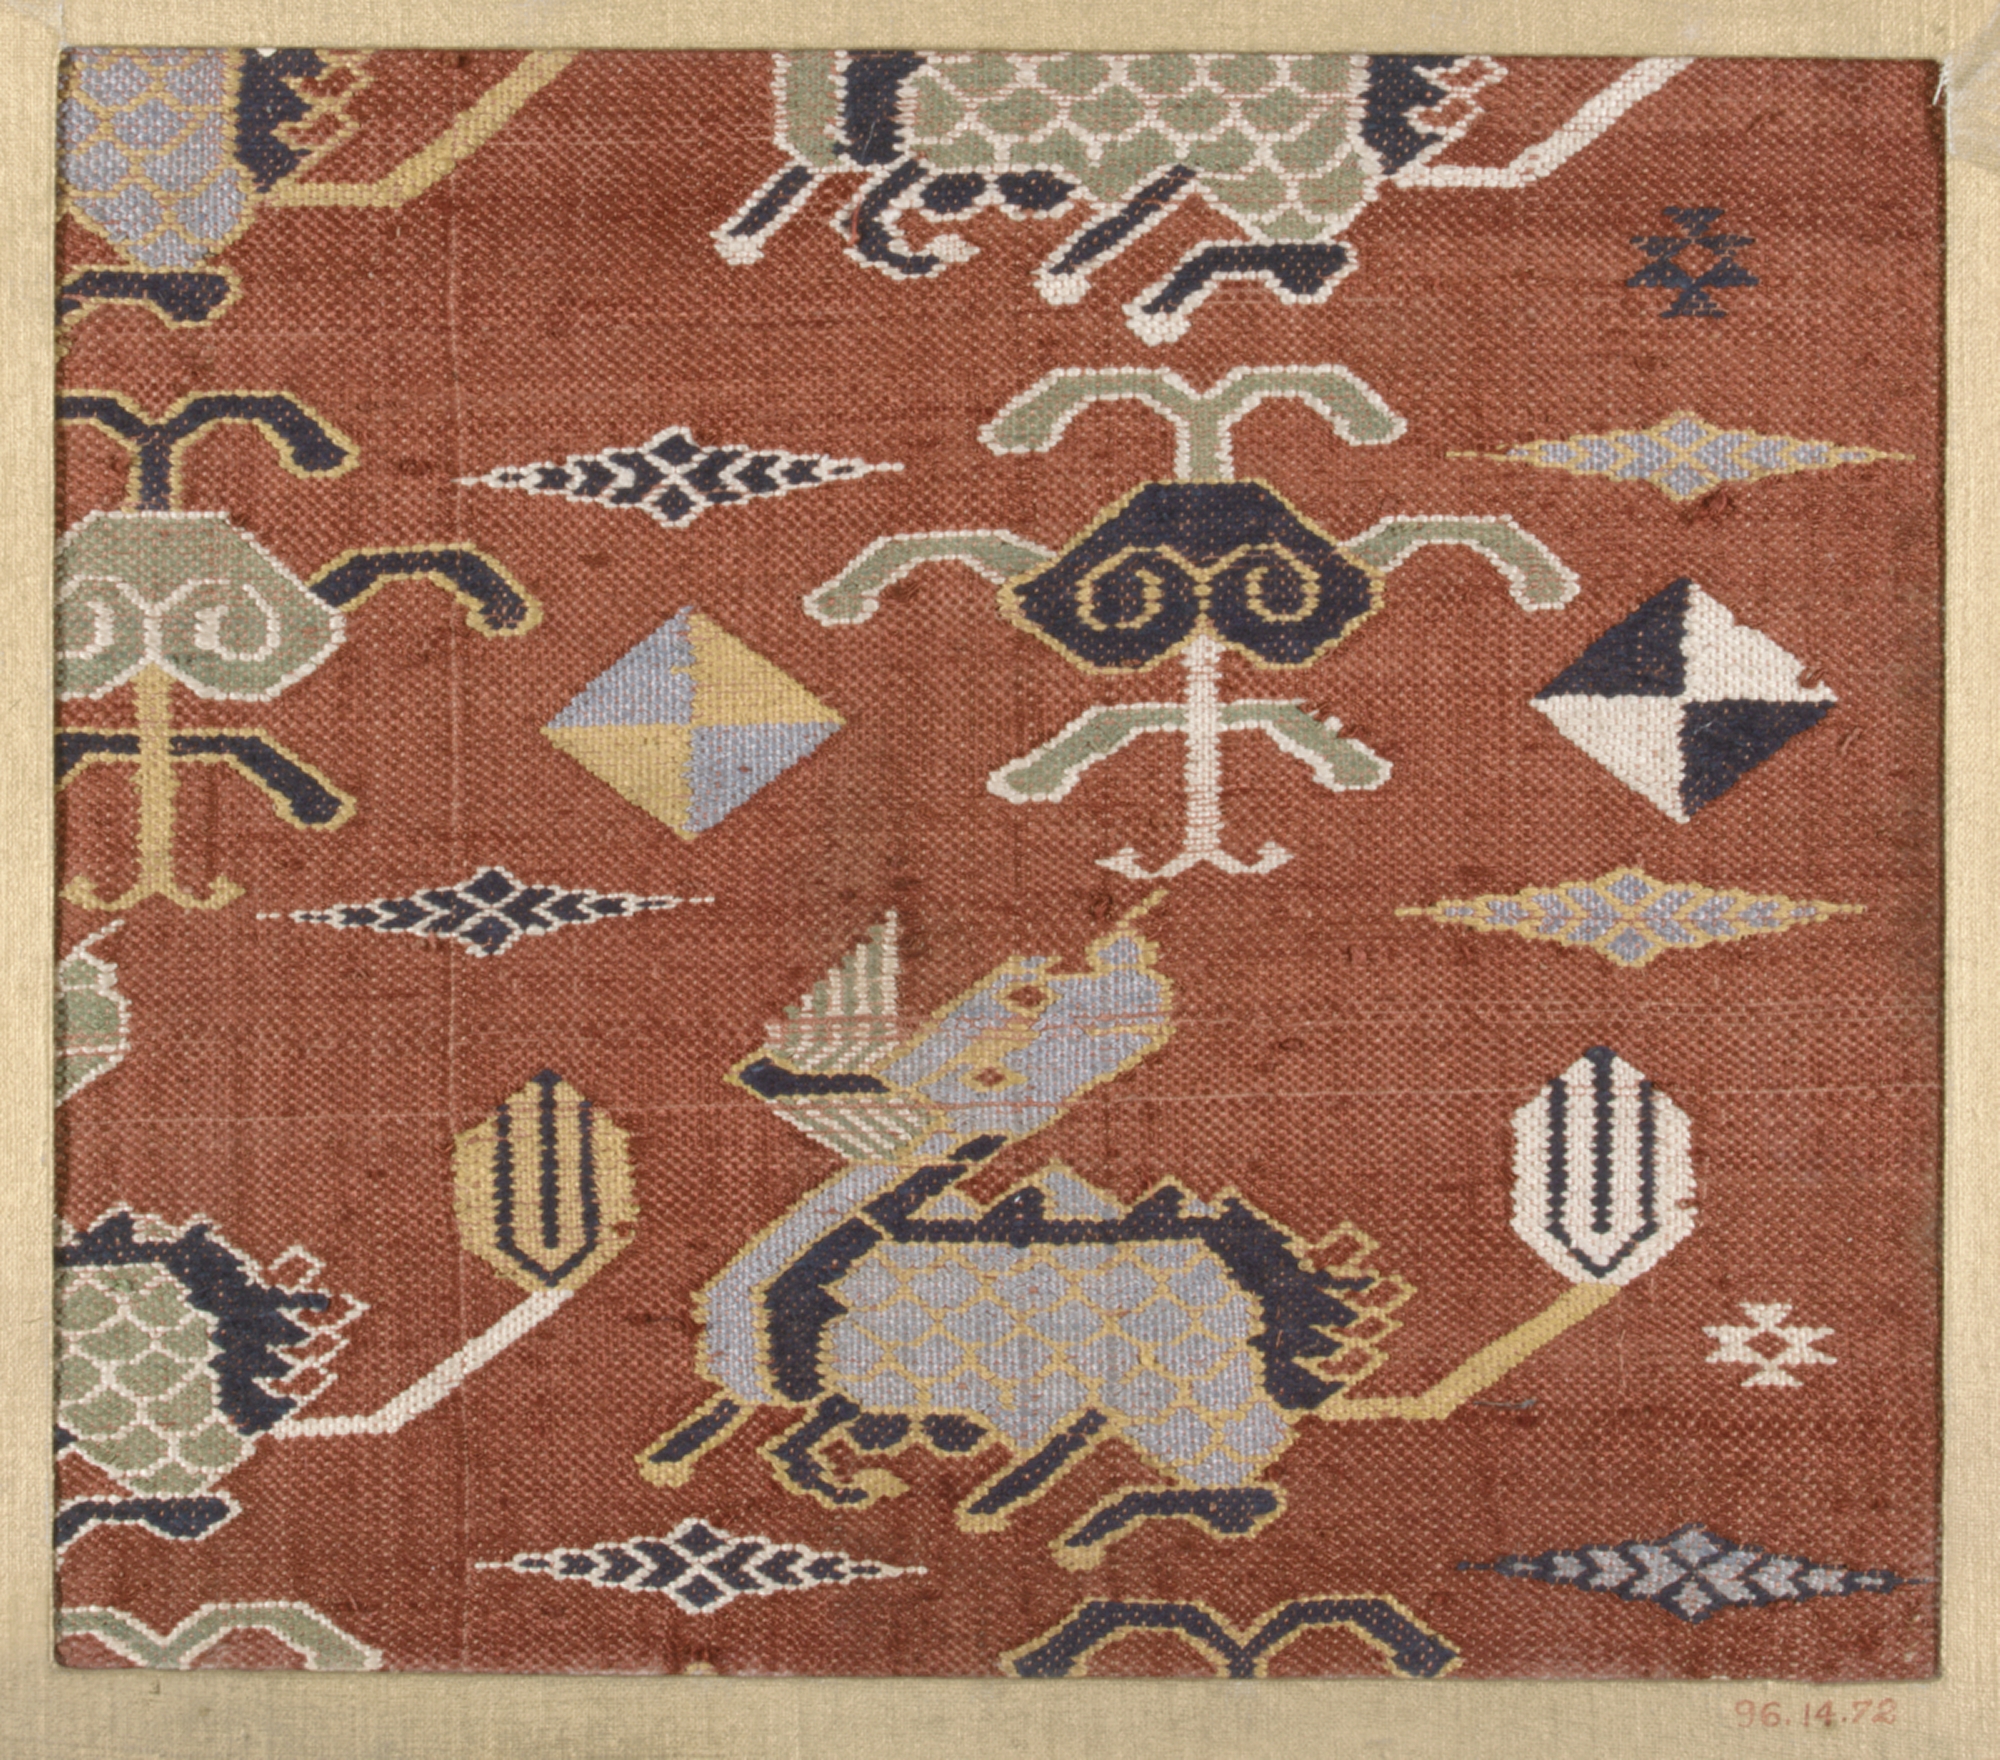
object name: piece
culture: japanese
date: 1701-1900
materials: silk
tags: animals